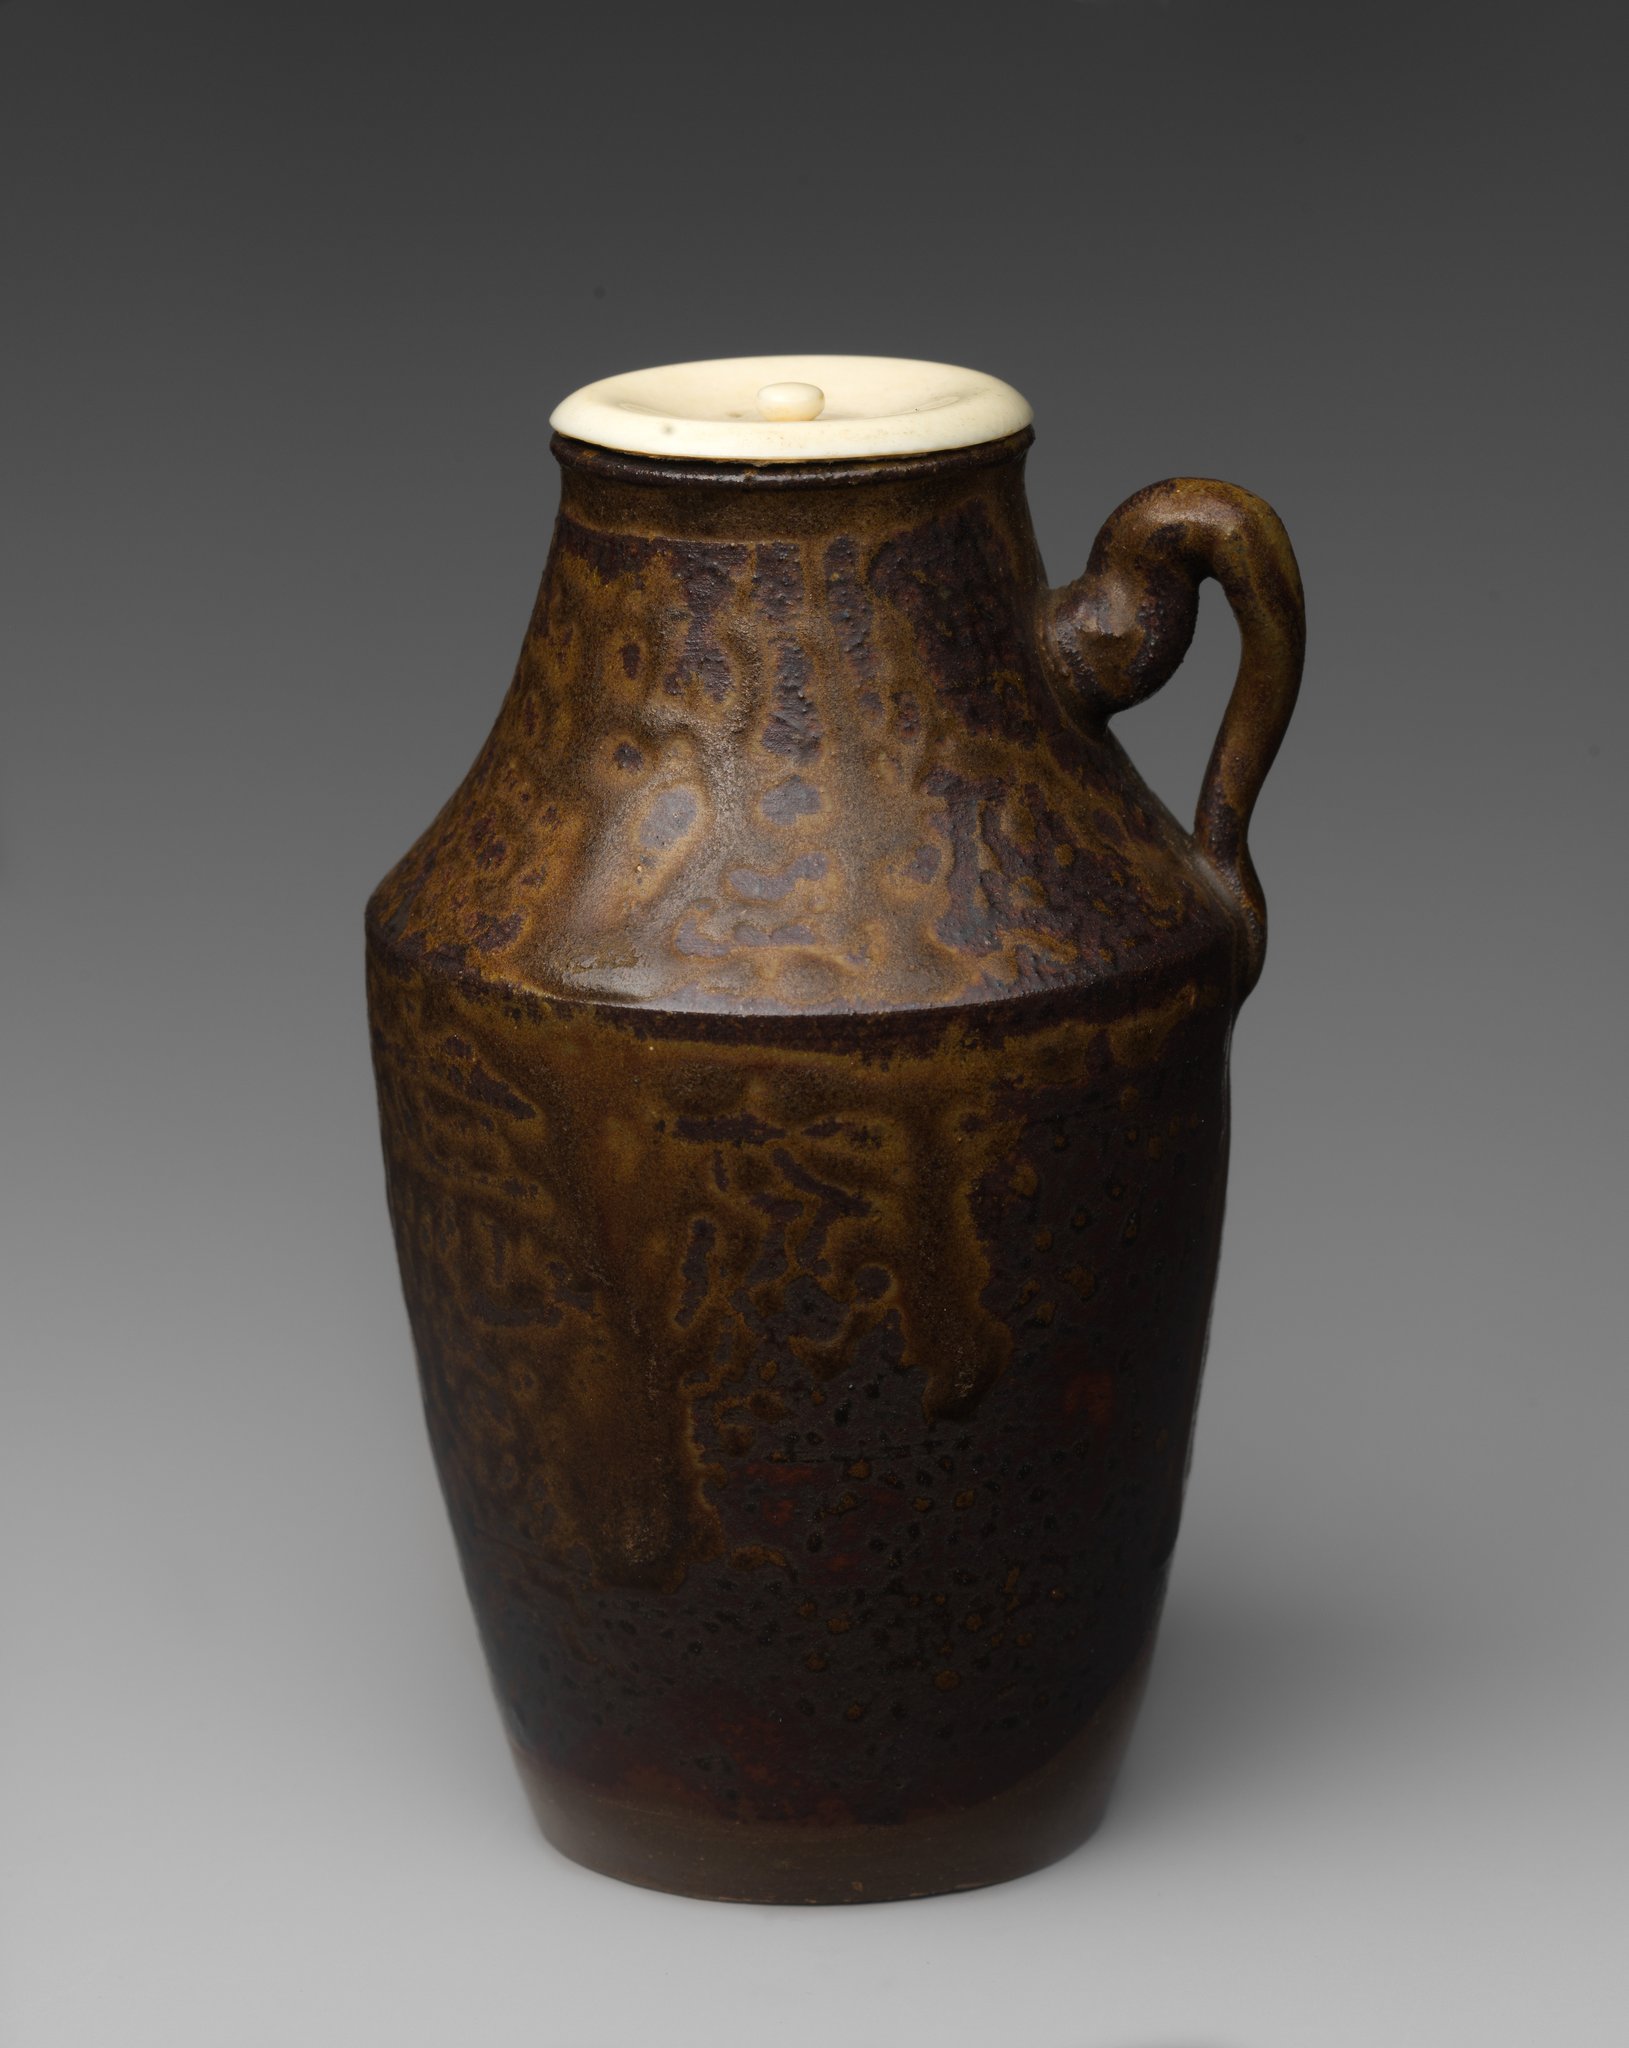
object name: tea jar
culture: japanese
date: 1601-1700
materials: glaze, pottery